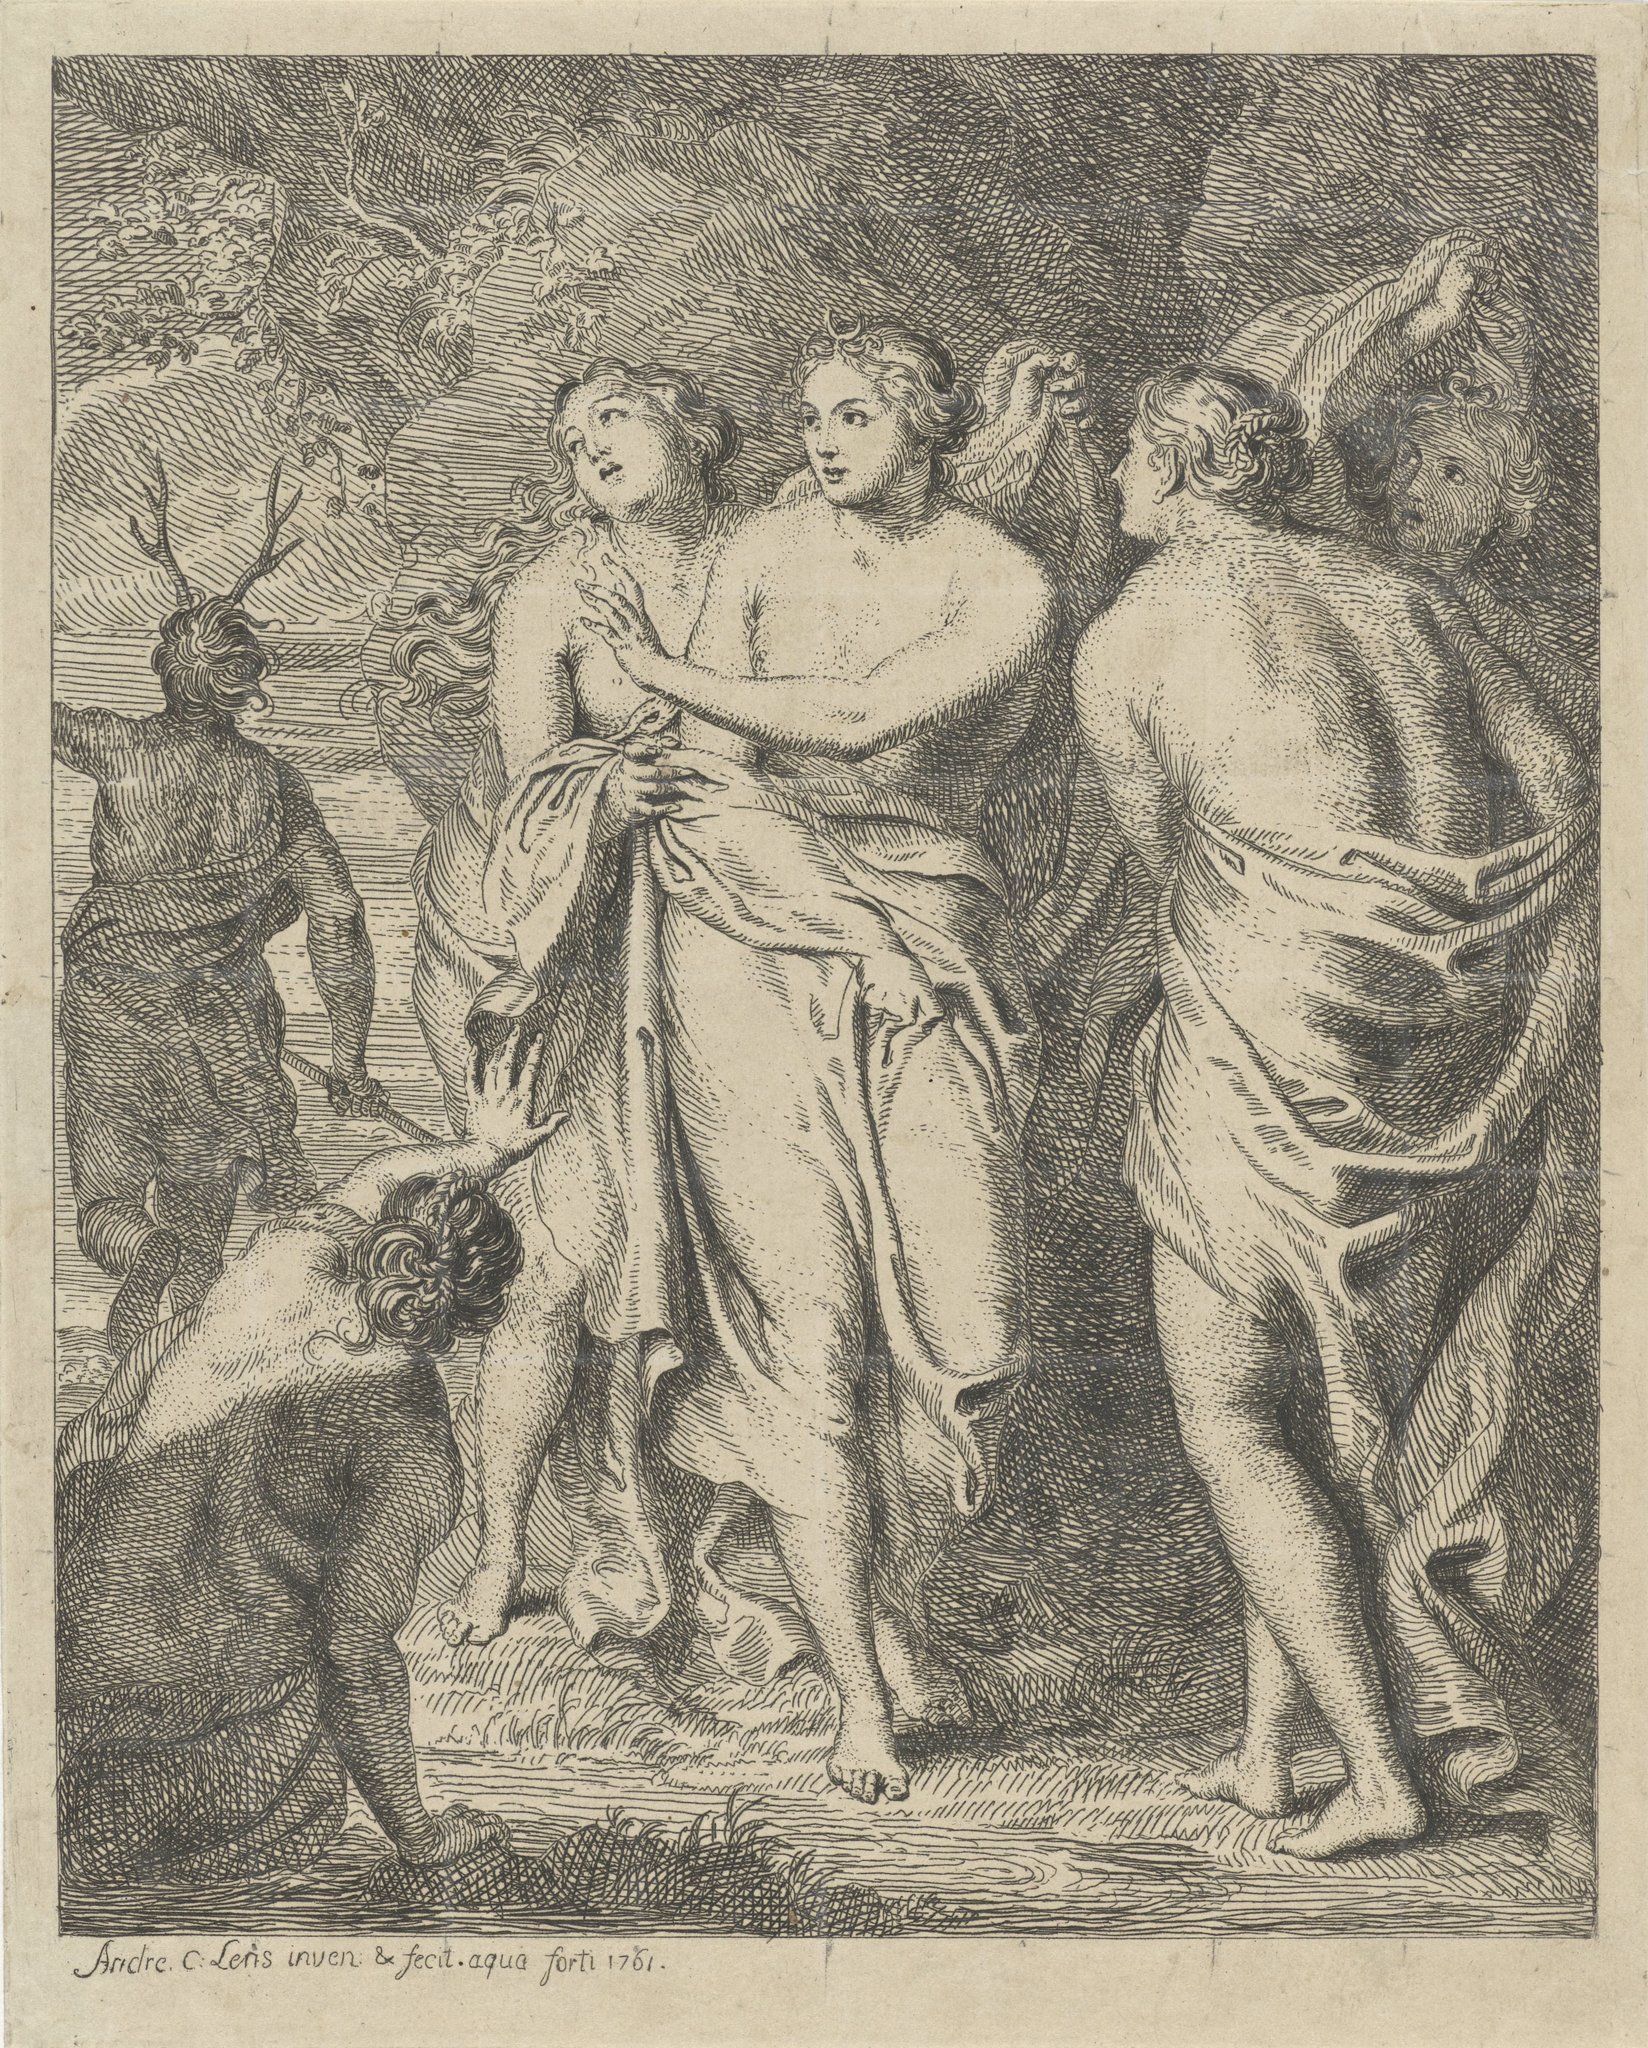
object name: print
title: Diana en Actaeon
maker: andries lens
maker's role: print maker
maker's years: 1739-1822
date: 1761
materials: paper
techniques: etching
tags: actaeon changed into a stag: as punishment for seeing her bathe, diana changes actaeon, the hunter, into a stag (ovid, metamorphoses iii 193)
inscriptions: collector's mark: Lugt 2228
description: Diana wordt omringd door drie nimfen, een vierde nimf bevindt zich op de voorgrond in het water. Links is Actaeon met een speer in de hand op de vlucht geslagen.